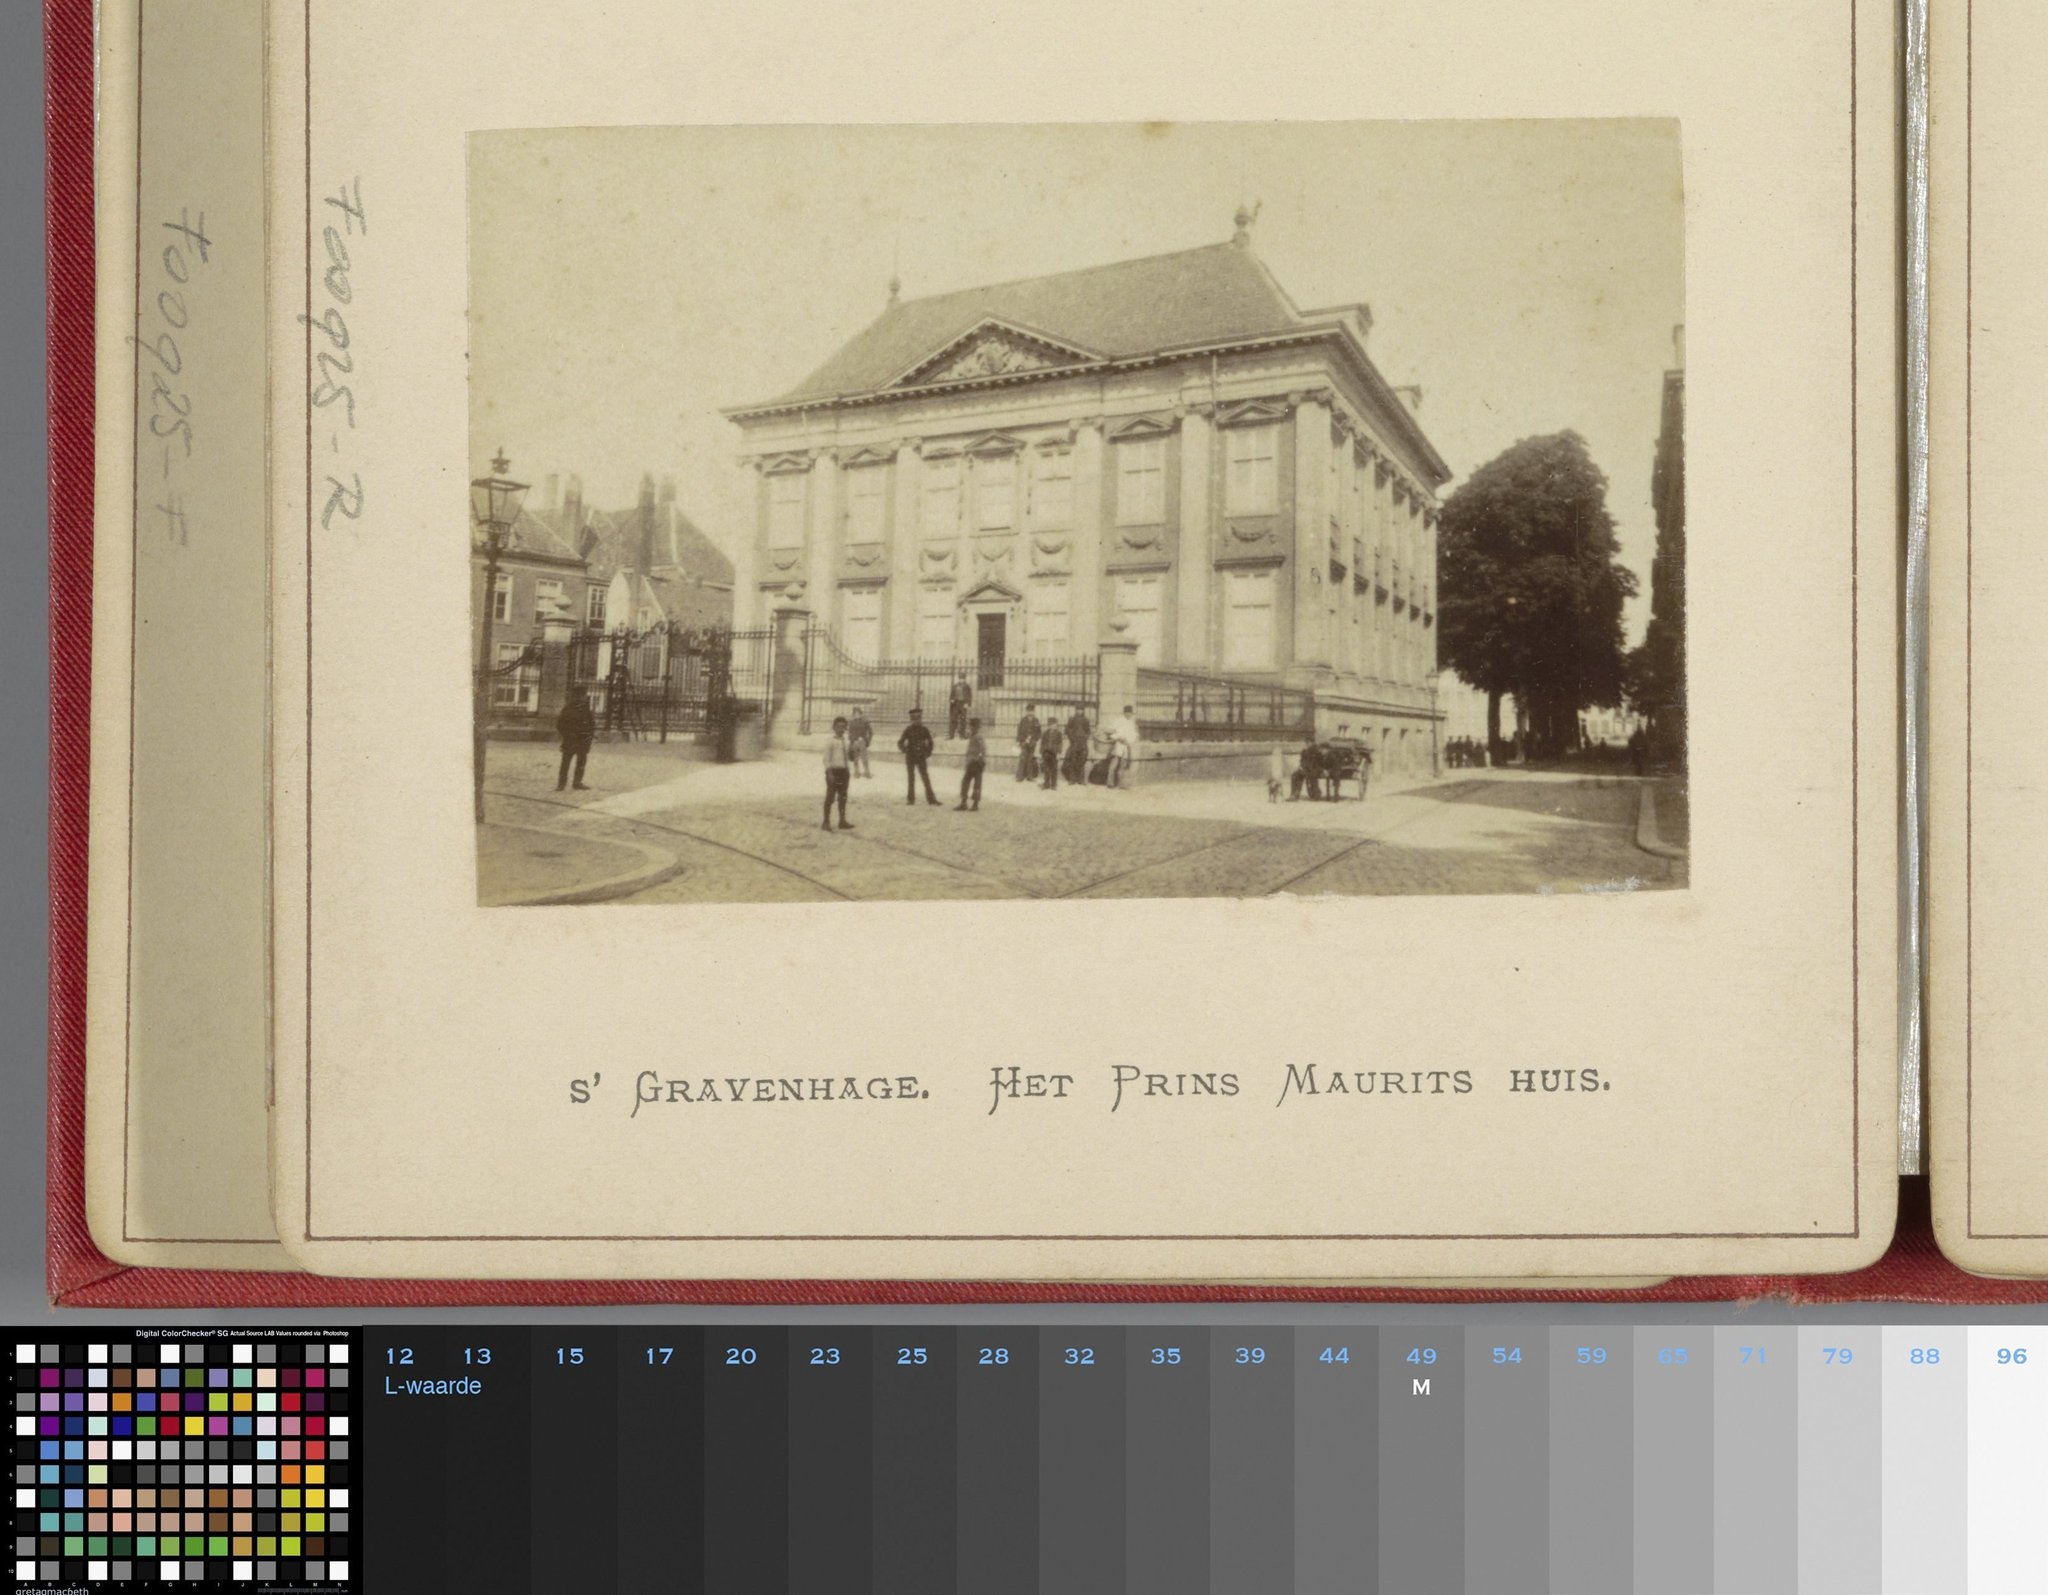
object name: album leaf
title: Gezicht op het Mauritshuis in Den Haag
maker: andries jager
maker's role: publisher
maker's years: 1825-1905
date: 1860-1900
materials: cardboard, photographic support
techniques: albumen print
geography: the hague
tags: palace, permanent exhibition, museum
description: Onderdeel van Fotoalbum met opnames van steden in Noord- en Zuid-Holland en Utrecht.